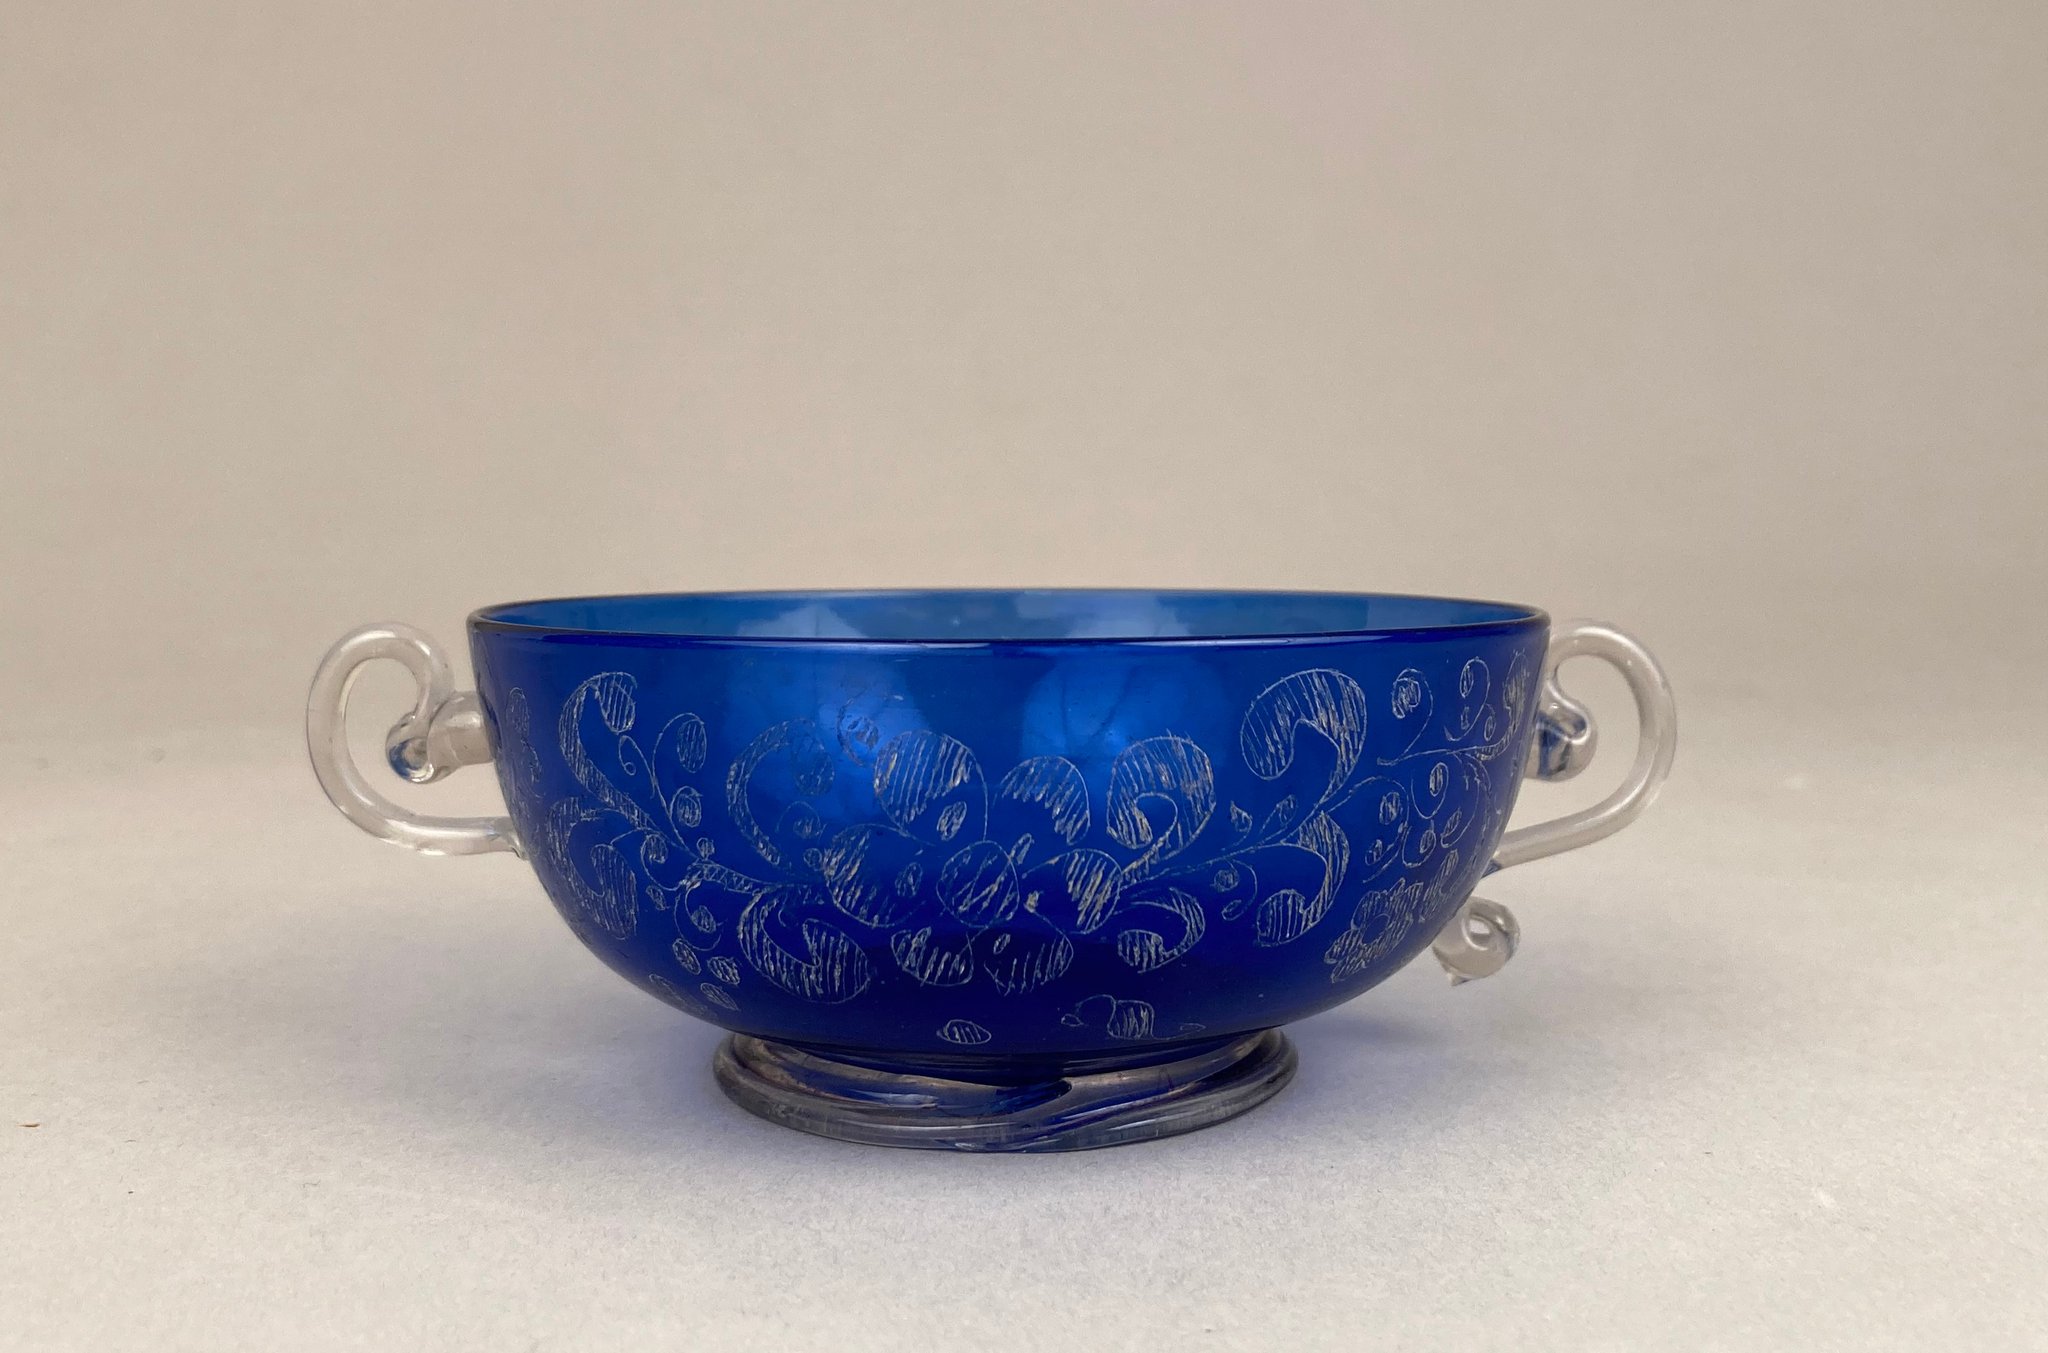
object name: cup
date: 1601-1733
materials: glass